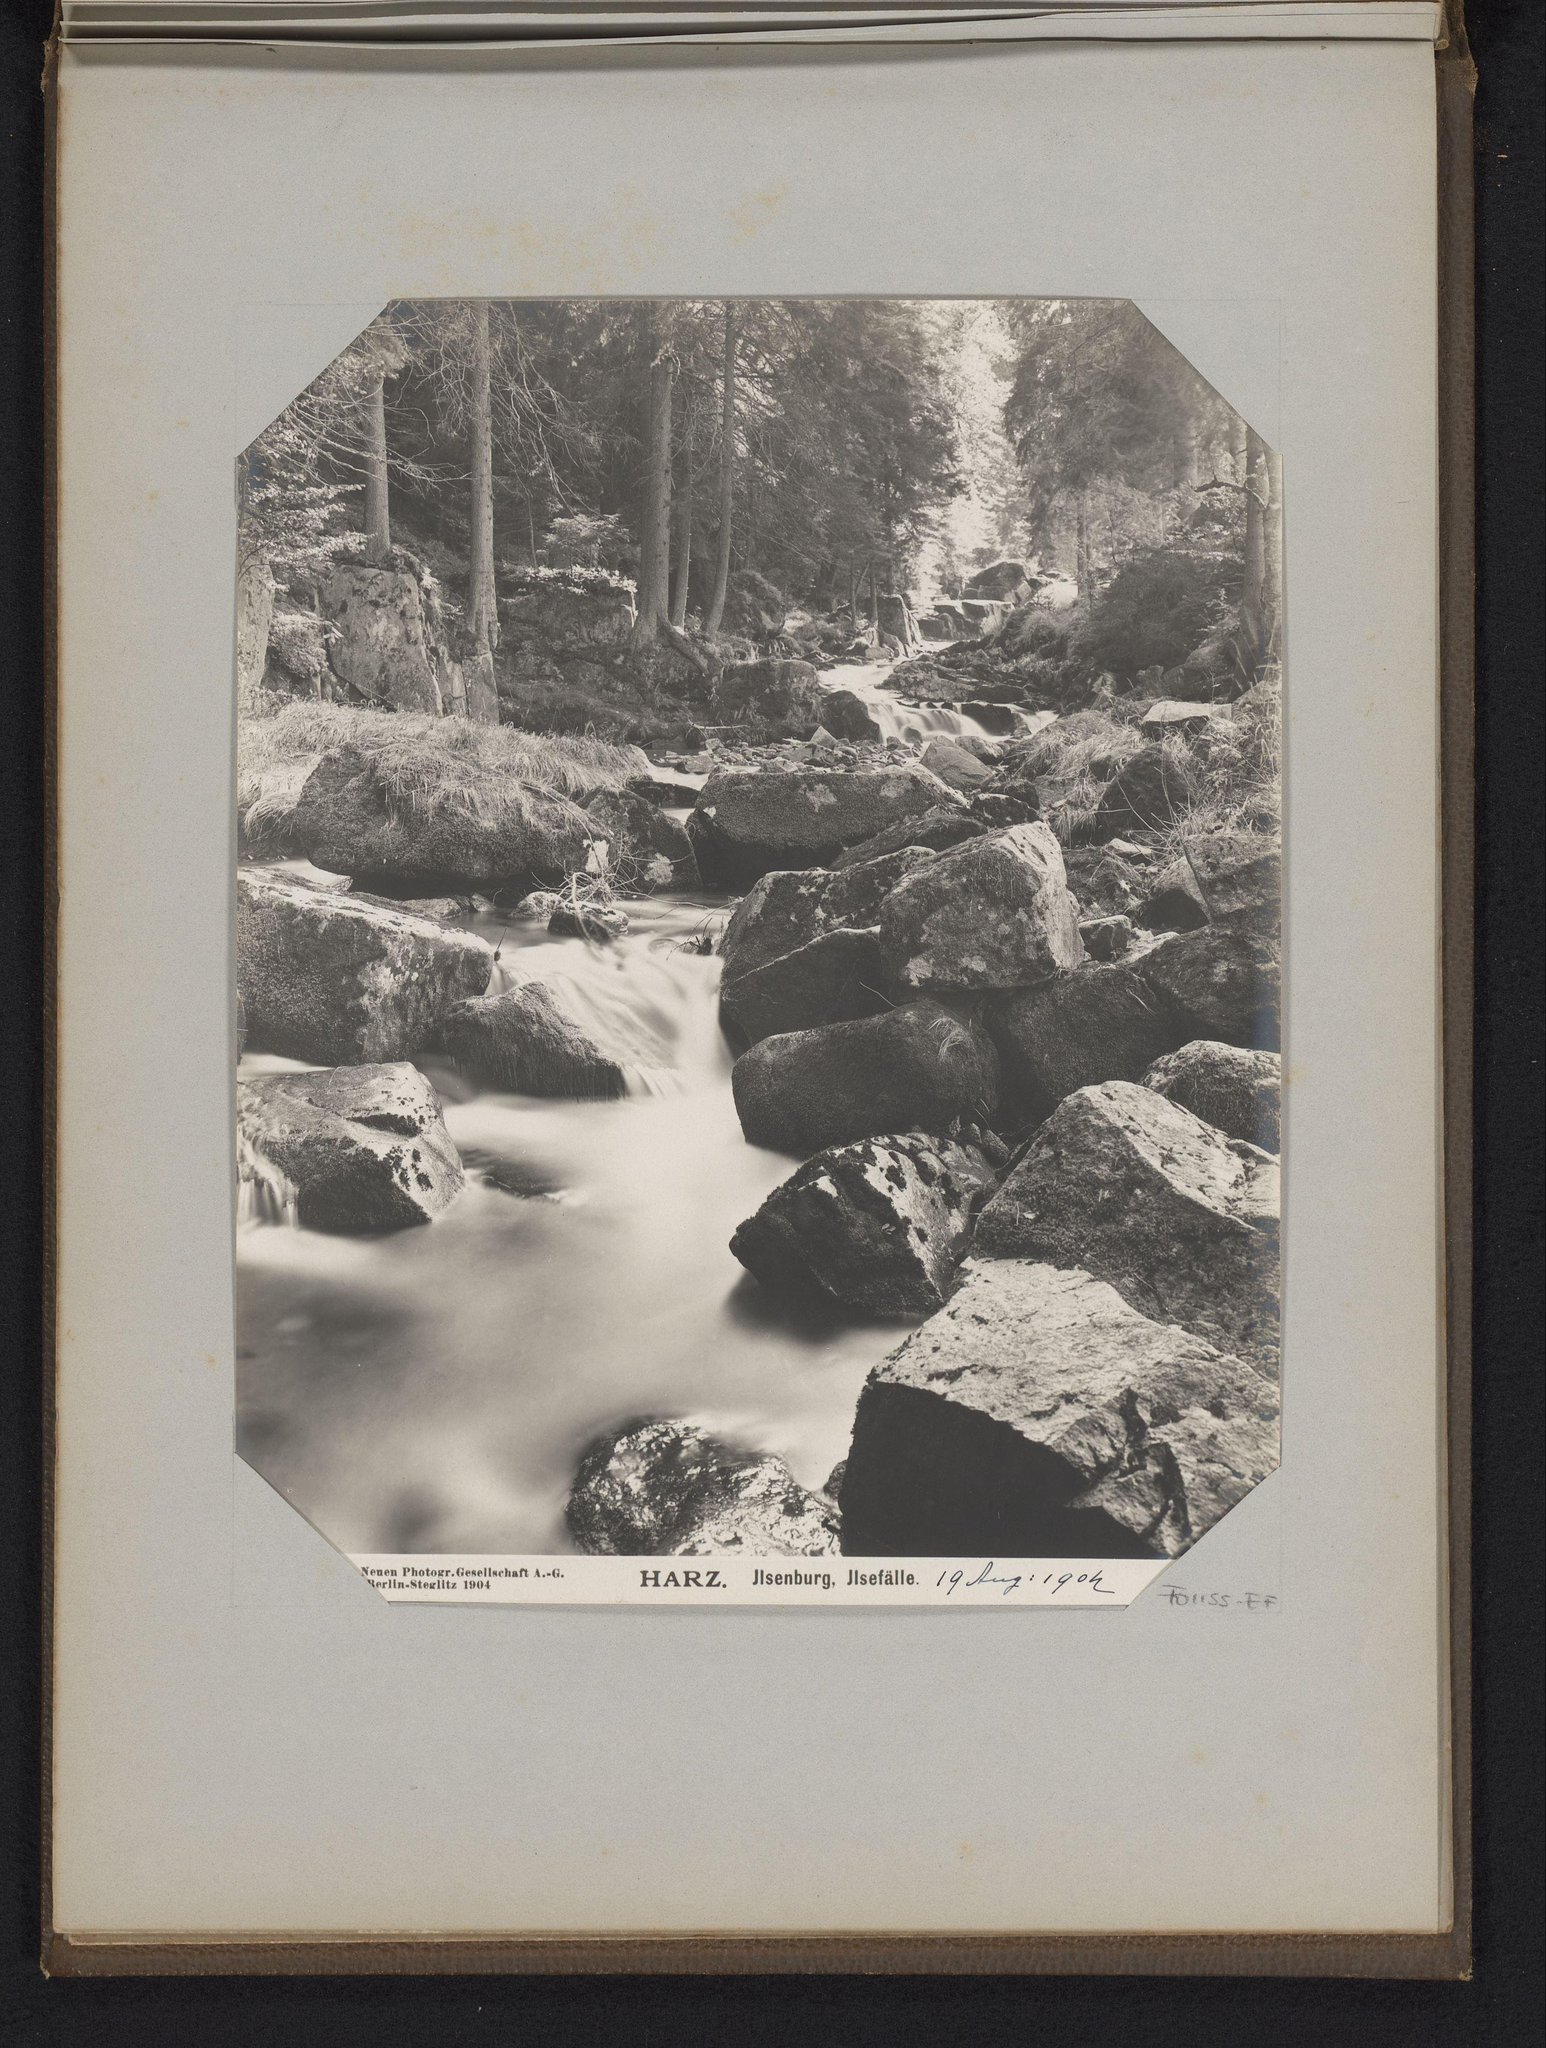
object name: photograph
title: Gezicht op de Ilsefalle te Ilsenburg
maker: Anonymous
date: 1904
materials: photographic support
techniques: gelatin silver print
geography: ilsenburg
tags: waterfall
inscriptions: date: ‘19 Aug: 1904’, inscription: ‘Verlag der Neuen Photogr. Gesellschaft A.-G./ Berlin-Steglitz 1904/ Harz. Ilsenburg, Ilsefälle./ 1642’